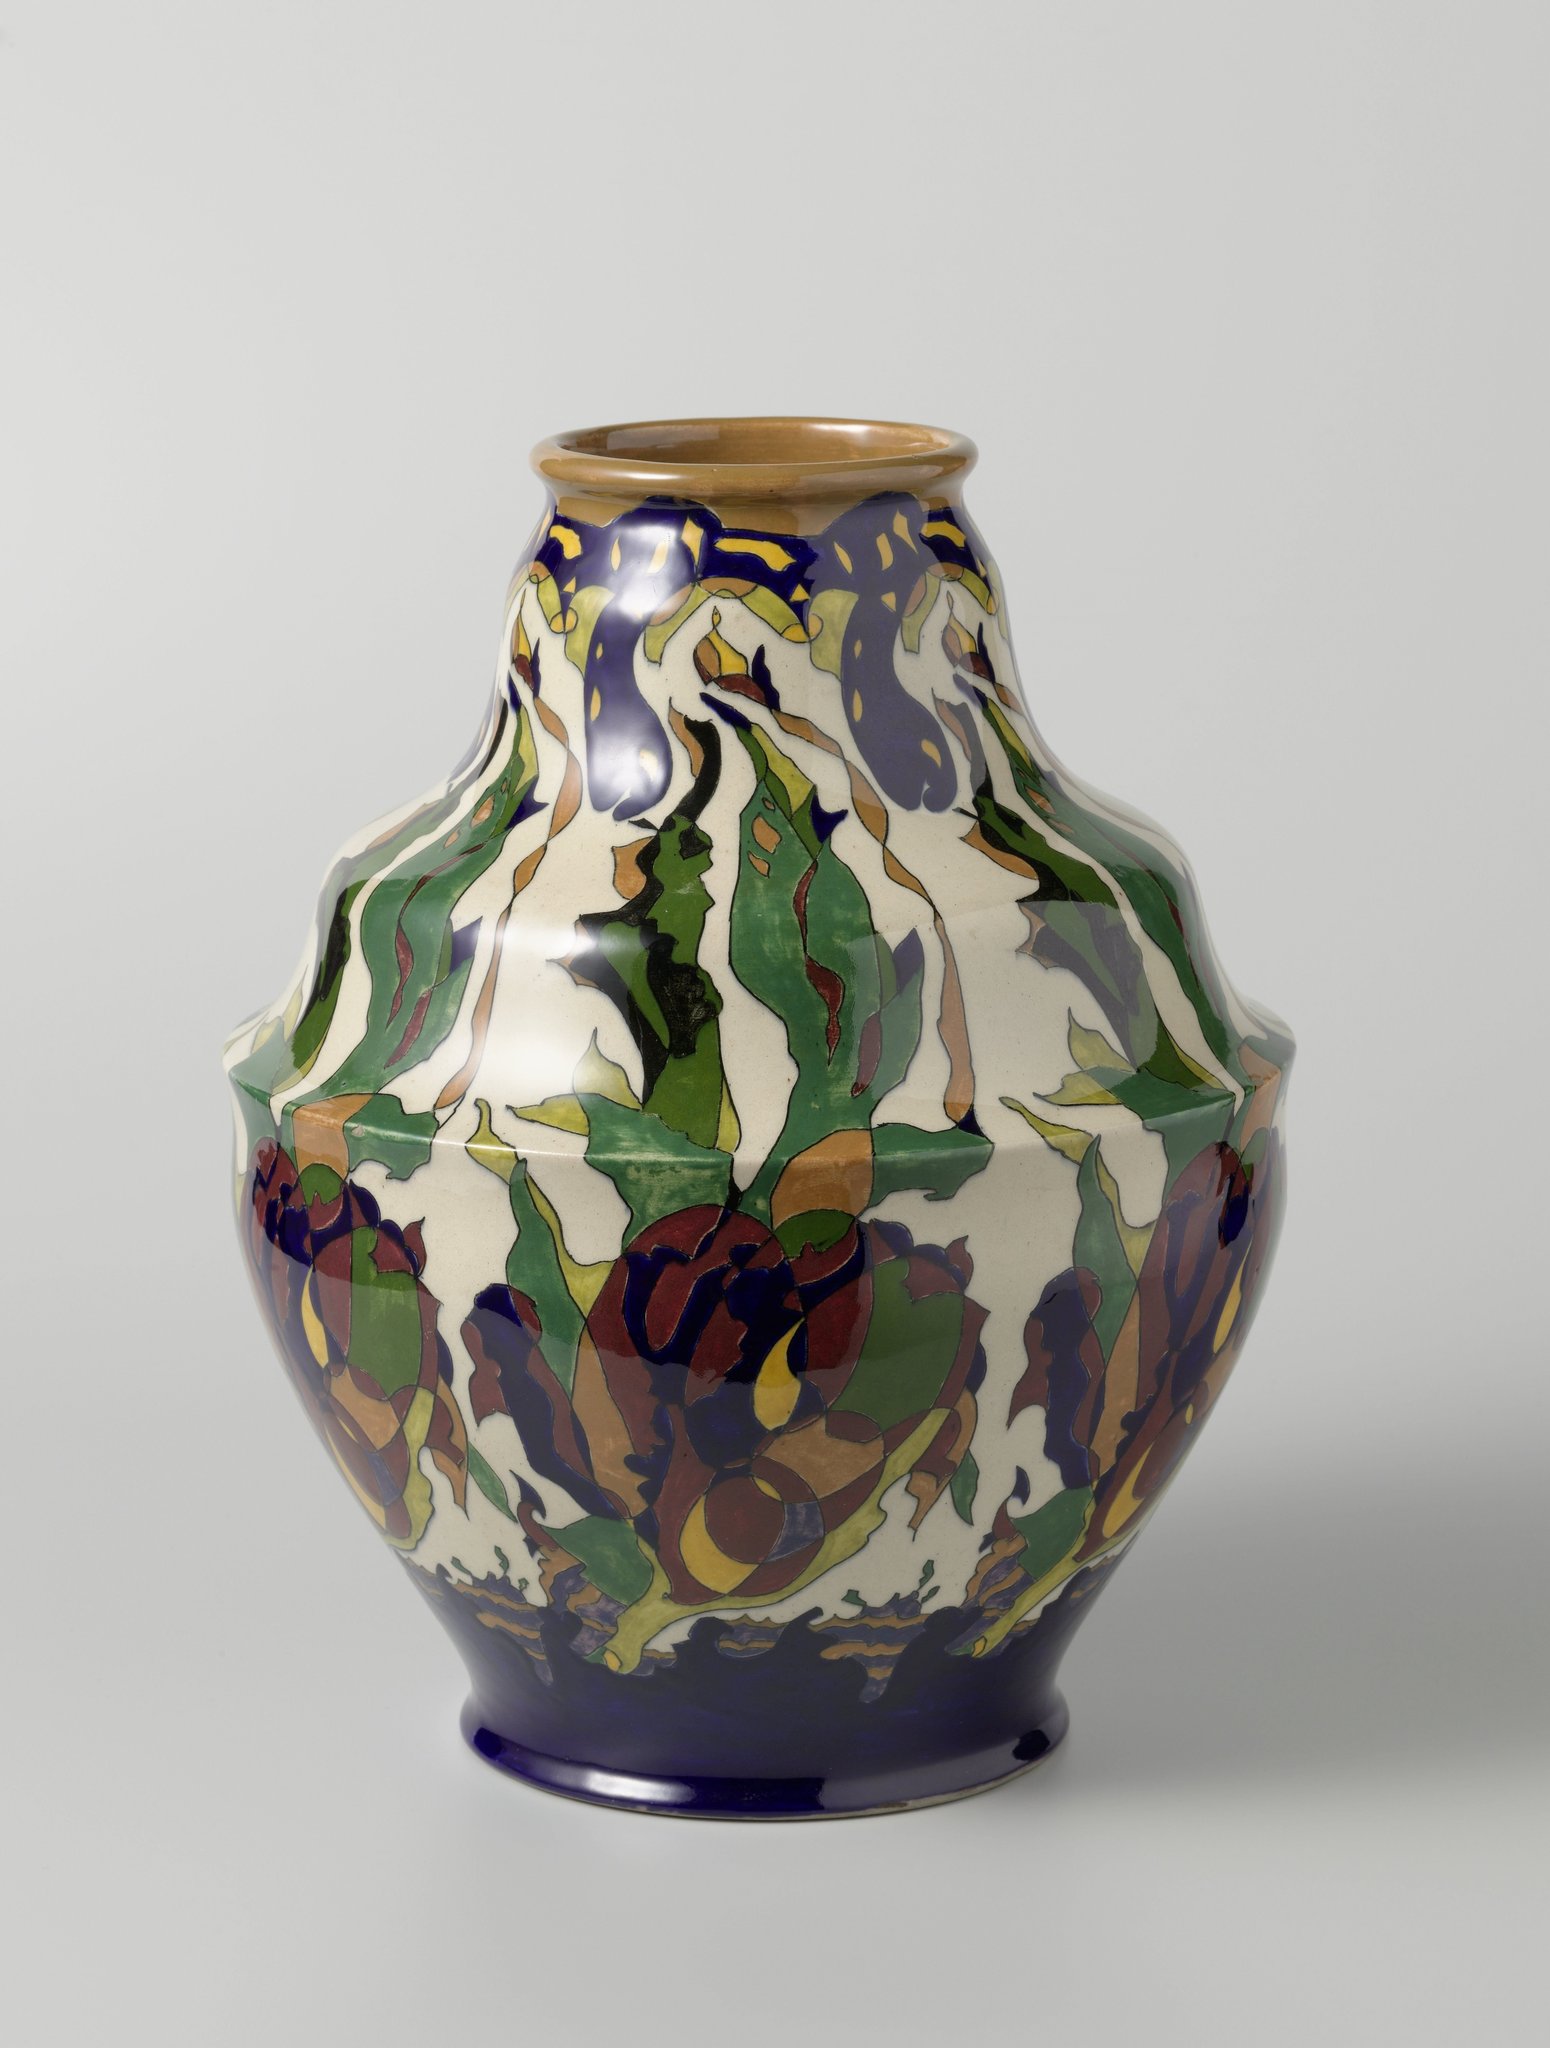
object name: vase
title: Vaas van aardewerk, polychroom beschilderd met het decor Tulpen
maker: theo colenbrander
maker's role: draughtsman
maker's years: 1841-1930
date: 1922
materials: earthenware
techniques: painted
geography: arnhem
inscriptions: mark: ‘Arnhem, Holland, "Ram", patr. "Tulpen", AK, B.20 en ingegrift 20.’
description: Vaas van aardewerk, polychroom beschilderd met het decor Tulpen.